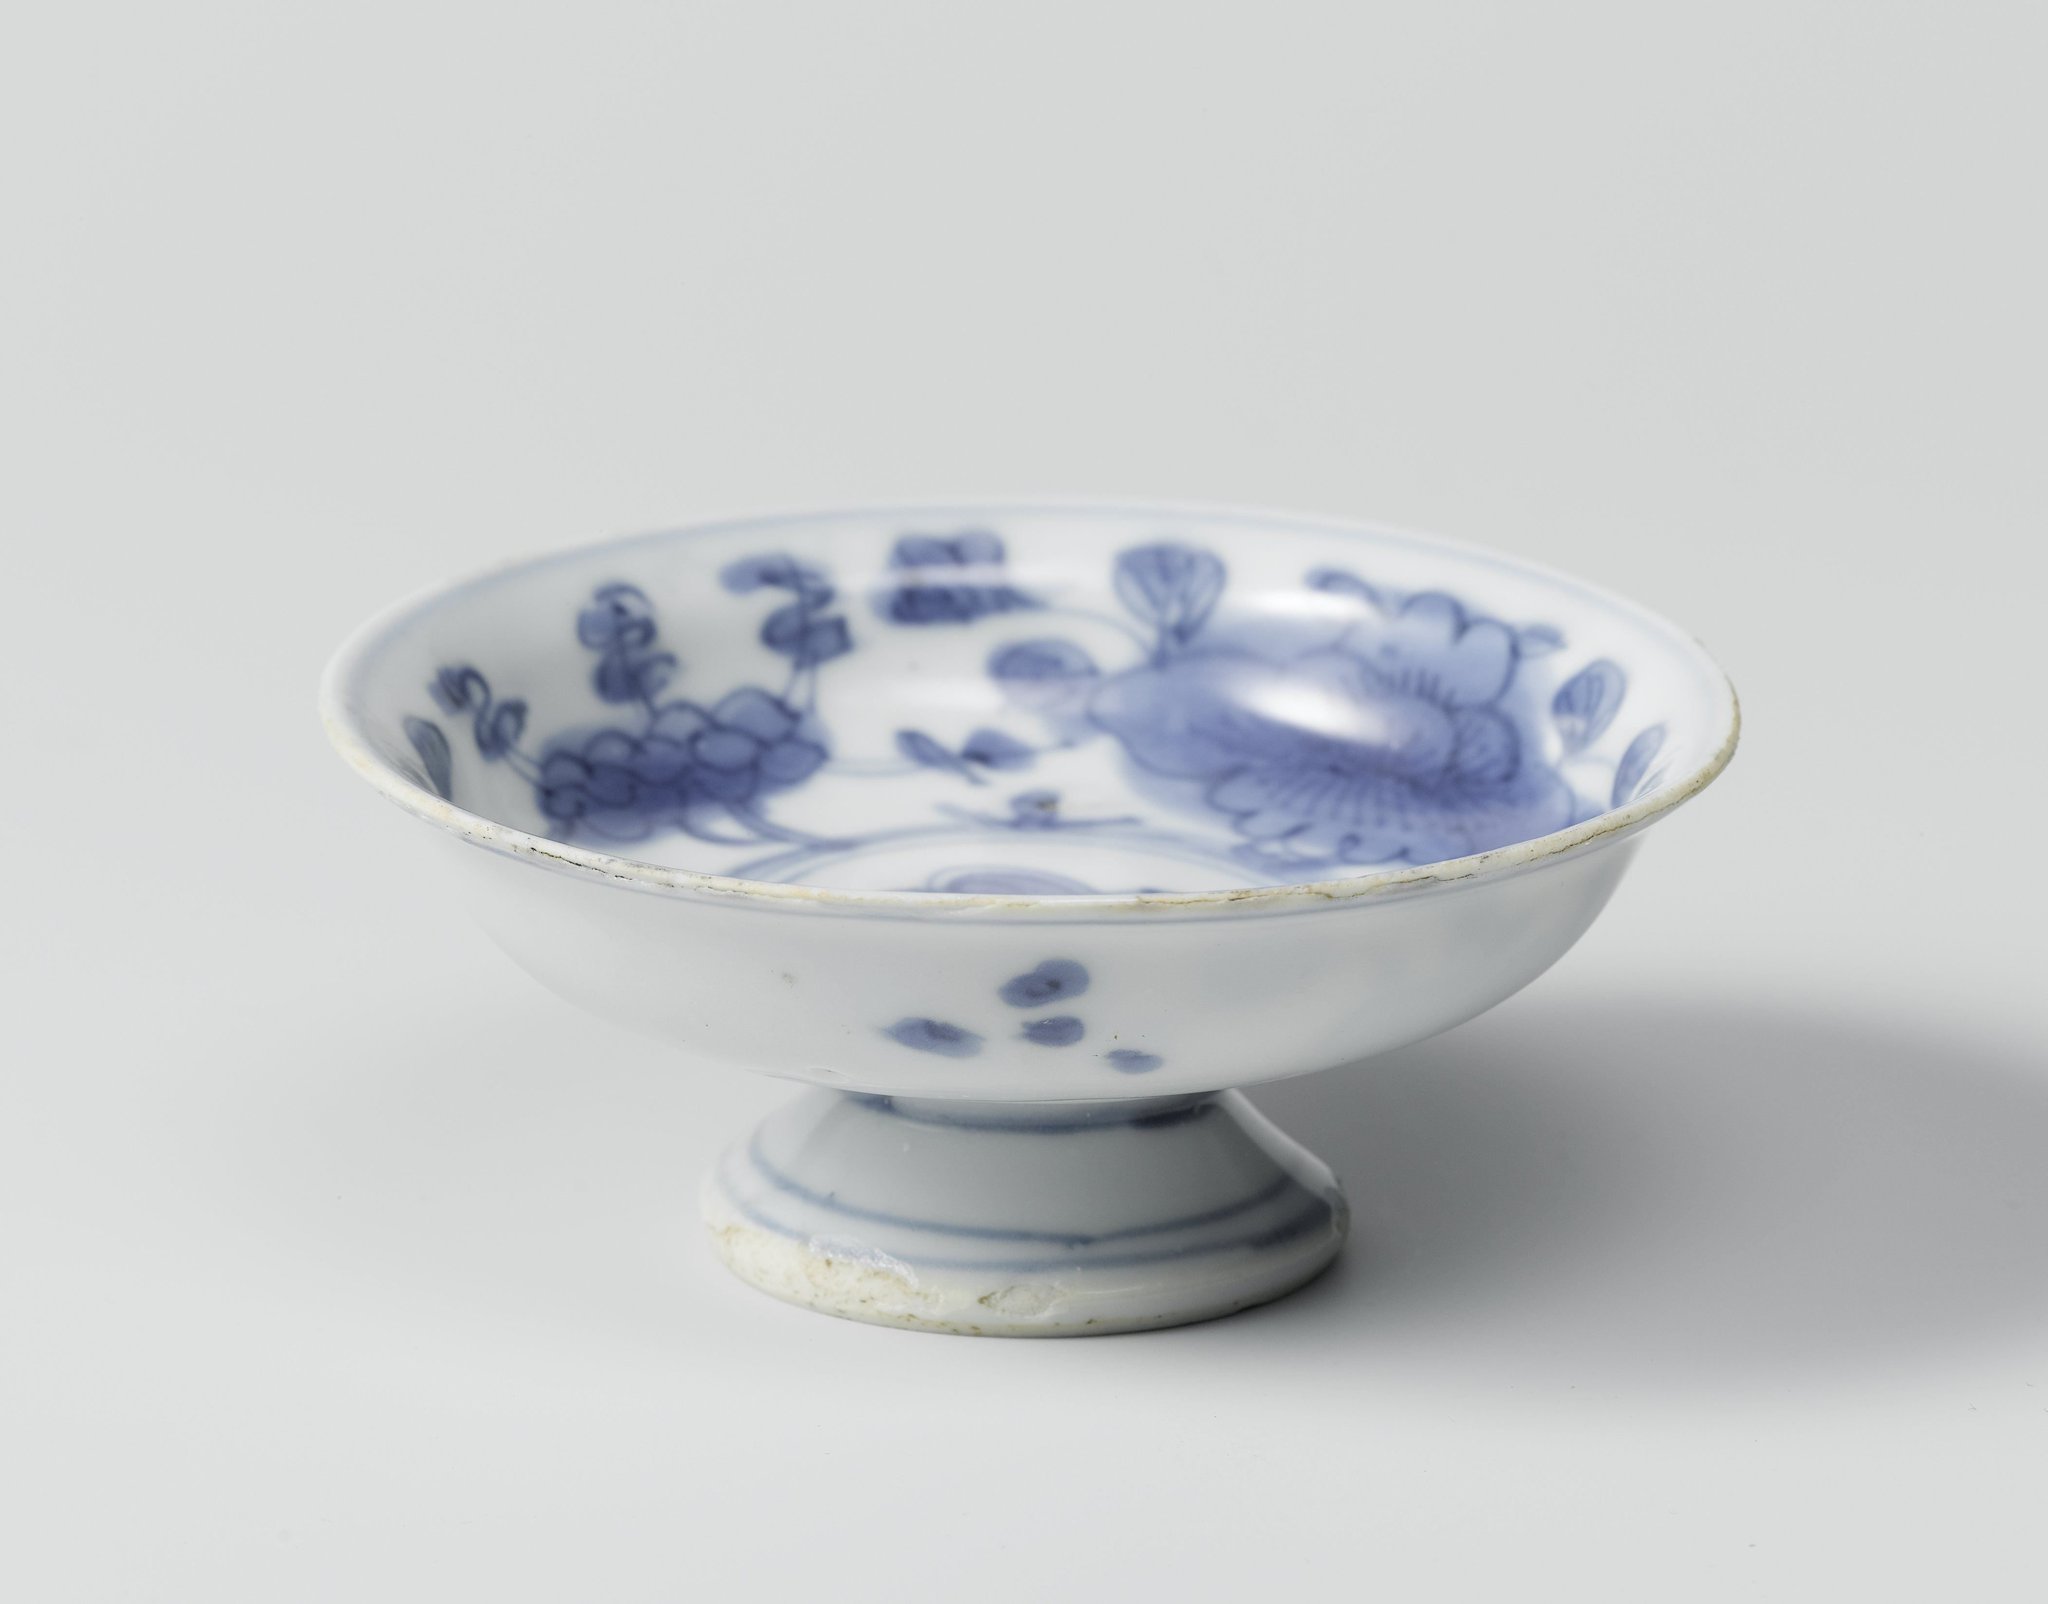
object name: tazza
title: Bowl with Floral Decorations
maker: Anonymous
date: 1600-1624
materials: cobalt, glaze, paint, porcelain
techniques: firing, turning, vitrification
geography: china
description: Tazza (schaal op voet) van porselein op een hoge, spreidende voet, beschilderd in onderglazuur blauw. Op het plat een ruyi-motief in een medaillon. De wand met vier bloemtakken (prunus, pioen, lotus, chrysant). De buitenwand met groepjes stippen. Op de voet drie blauwe lijnen. Kraakporselein in blauw-wit.